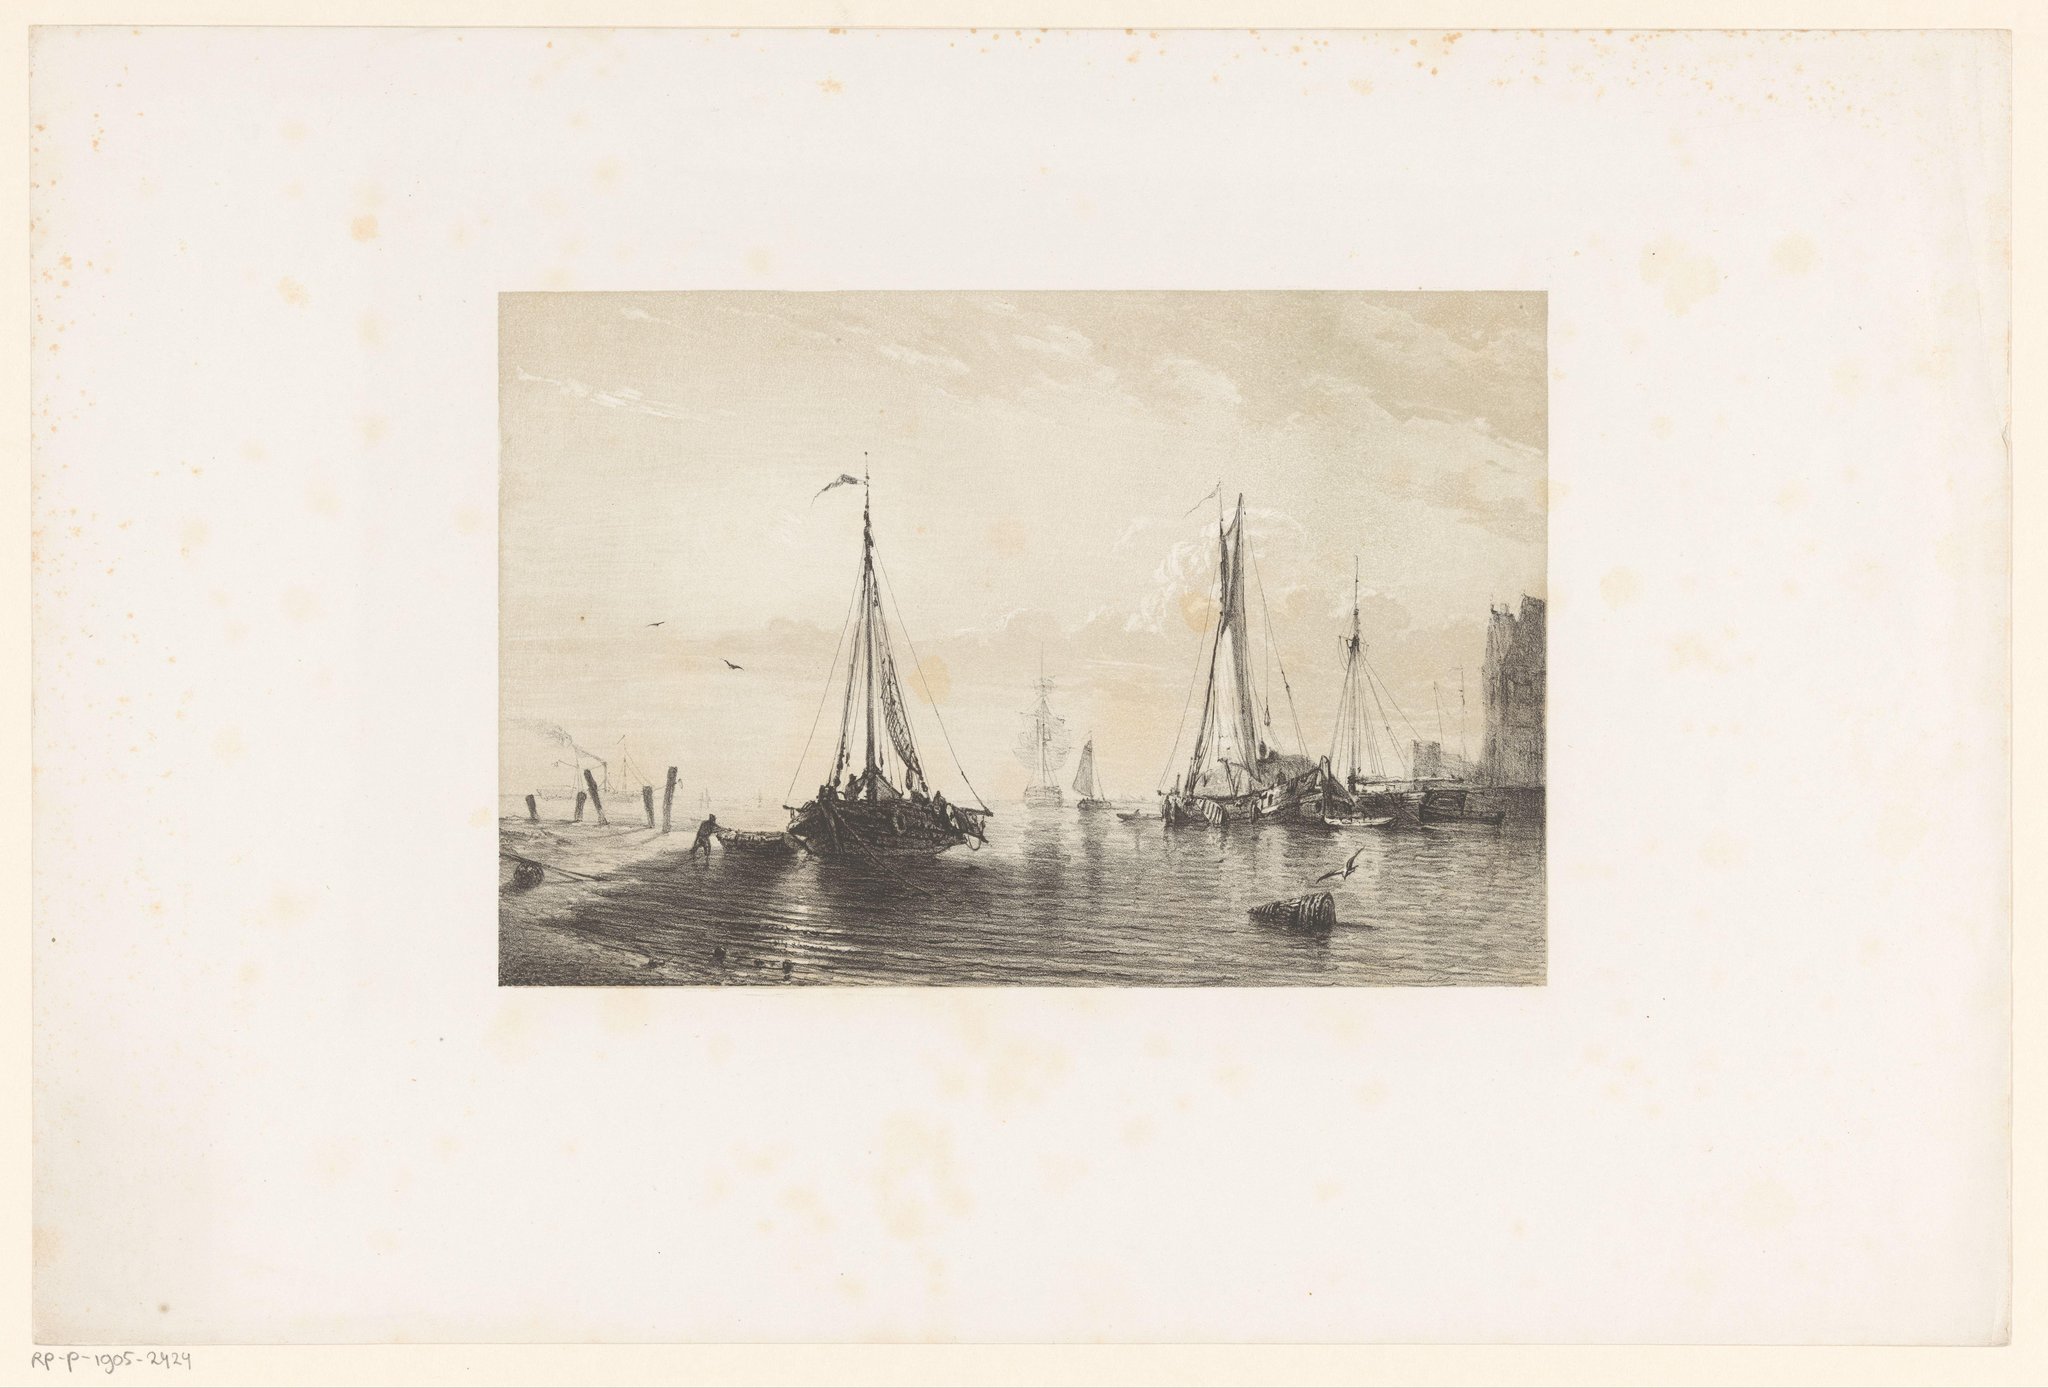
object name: print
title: Haven met verschillende zeilschepen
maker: Anonymous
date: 1809-1899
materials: paper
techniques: tone lithography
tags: harbour, sailing-ship, sailing-boat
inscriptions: collector's mark: Lugt 2228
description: Rechts is een kade te zien met enkele pakhuizen. Links is een man bezig een roeiboot aan wal te trekken.